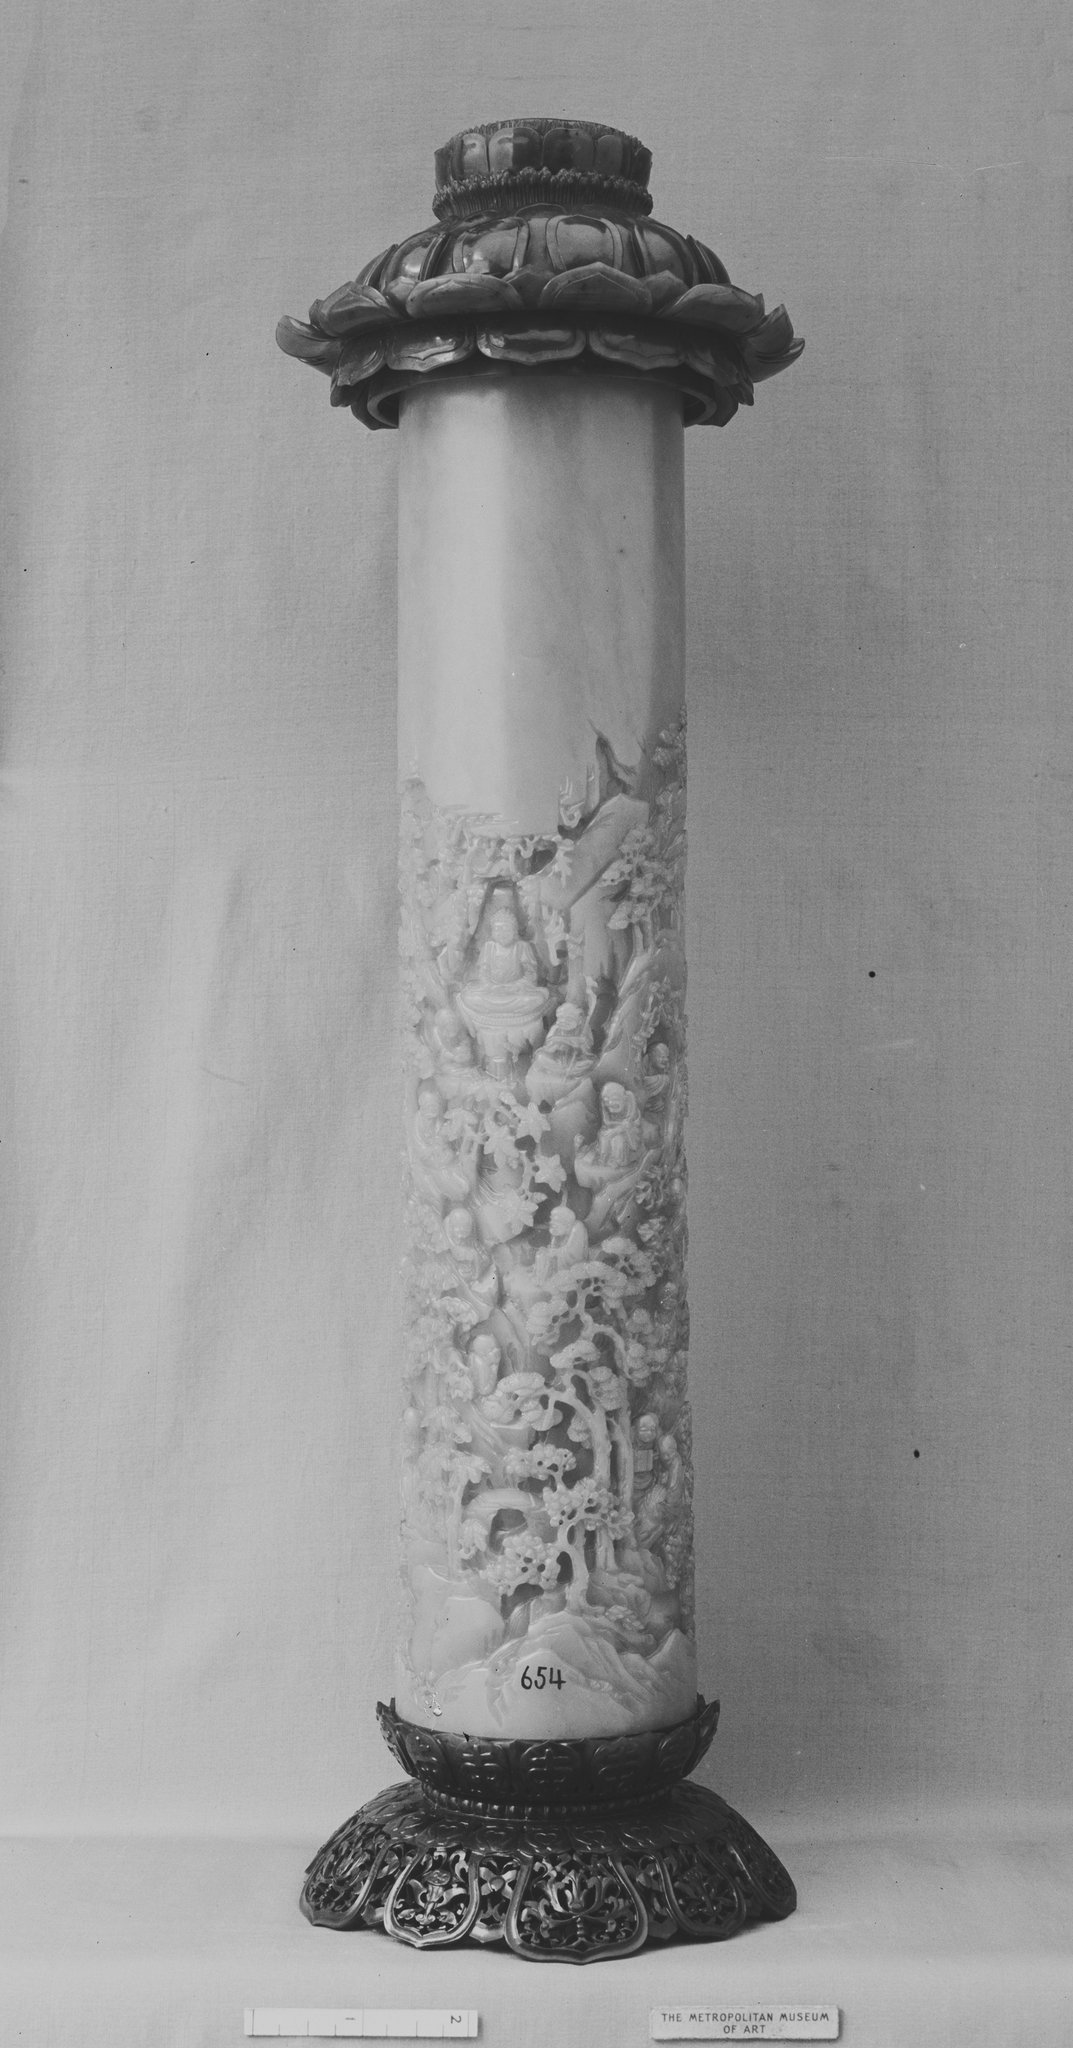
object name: column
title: Buddhist column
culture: chinese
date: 1736-1795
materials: jade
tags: mountains,buddhism,buddha